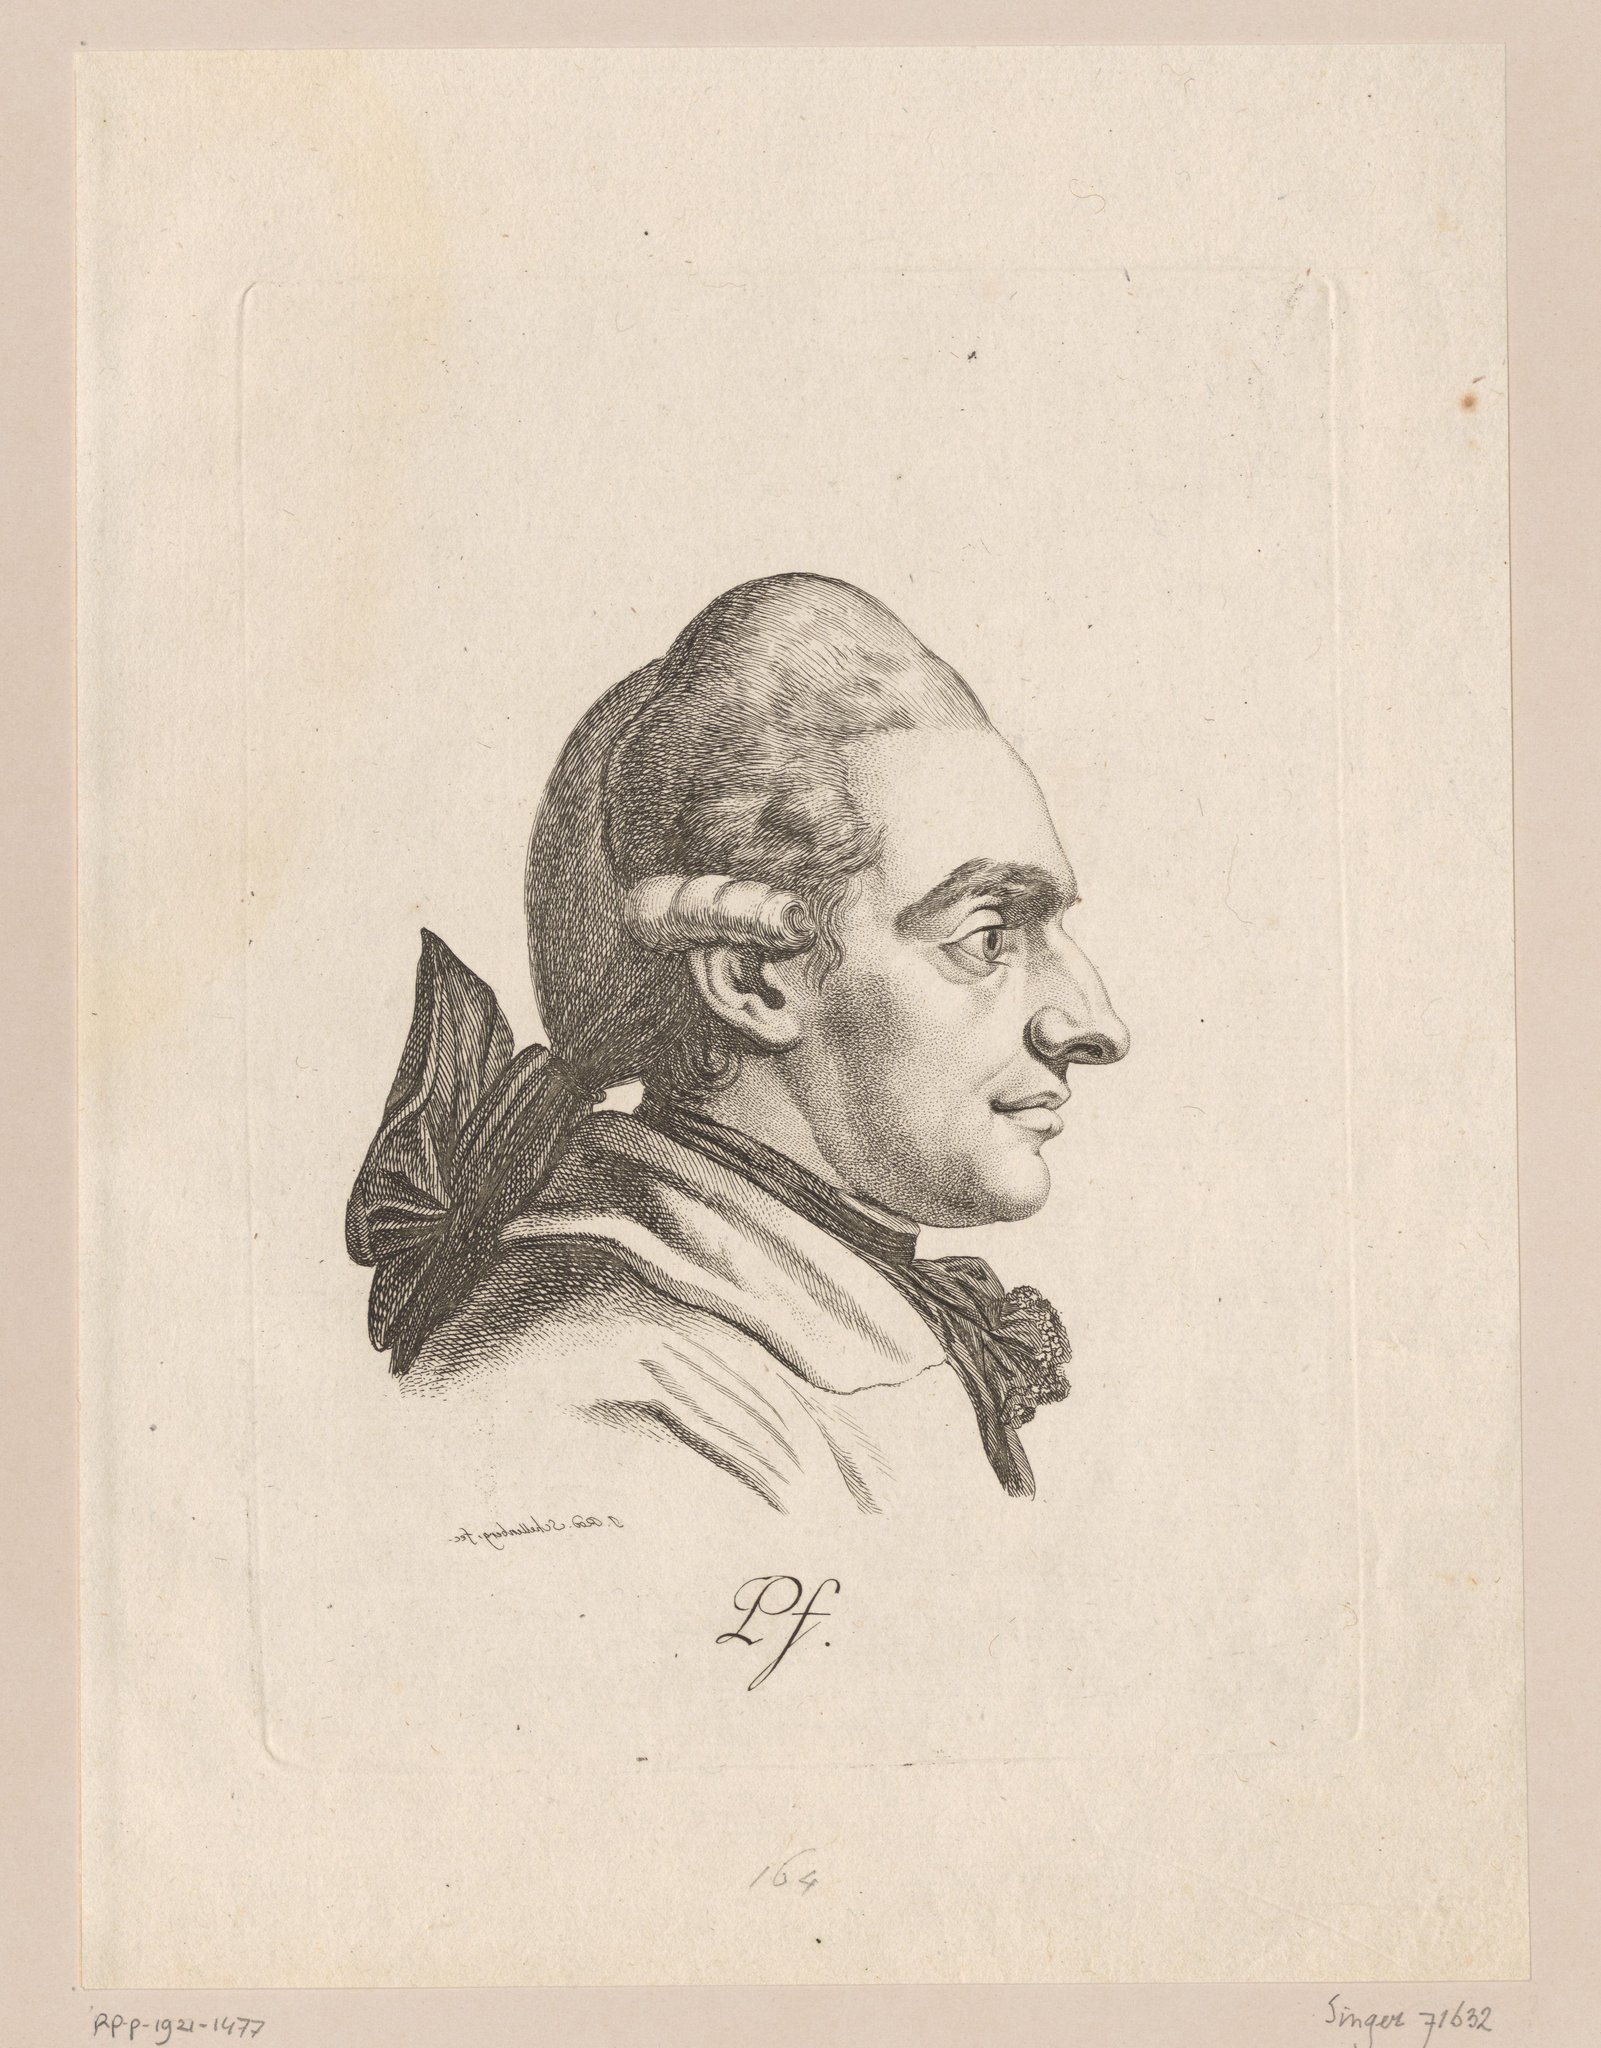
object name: print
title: Portret van Heinrich Pfenninger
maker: johann rudolph schellenberg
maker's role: print maker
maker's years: 1740-1806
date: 1769-1806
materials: paper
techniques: engraving, etching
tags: print maker, heinrich pfenninger, adult man, historical persons, portrait, self-portrait of artist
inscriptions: collector's mark: Lugt 2233